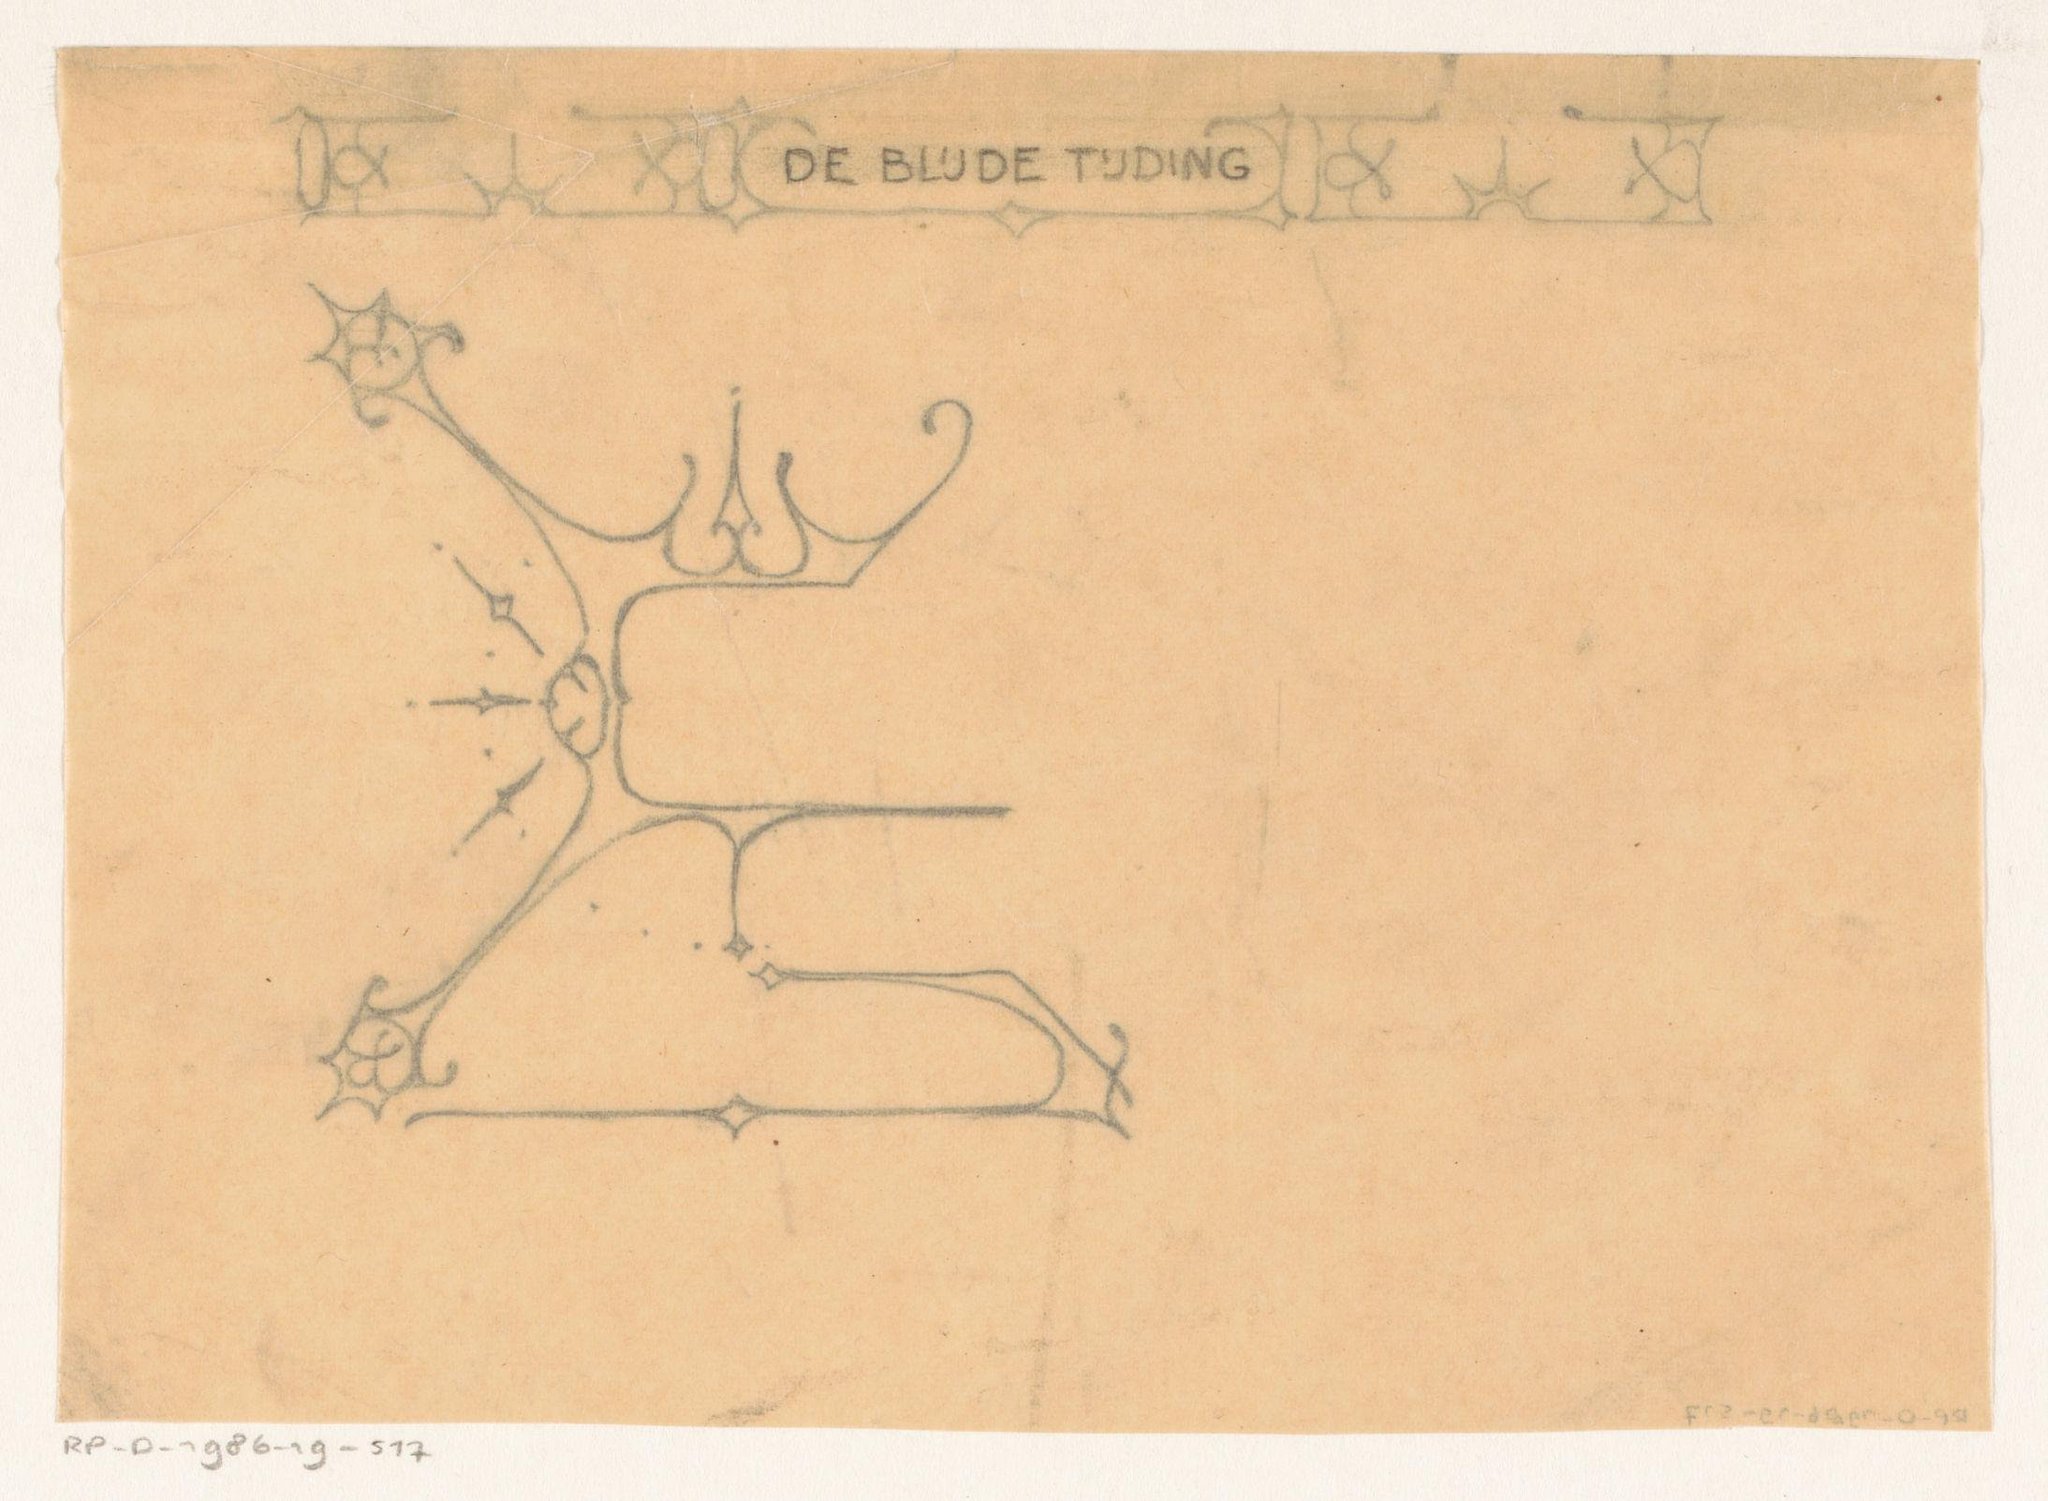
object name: drawing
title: De blijde tijding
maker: reinier willem petrus de vries (1874-1953)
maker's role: draughtsman, print maker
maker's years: 1874-1953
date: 1900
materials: pencil, paper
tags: ornament ~ starforms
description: Ontwerp voor een gedenkboek ter gelegenheid van het huwelijk van Koningin Wilhelmina en Hertog Hendrik.